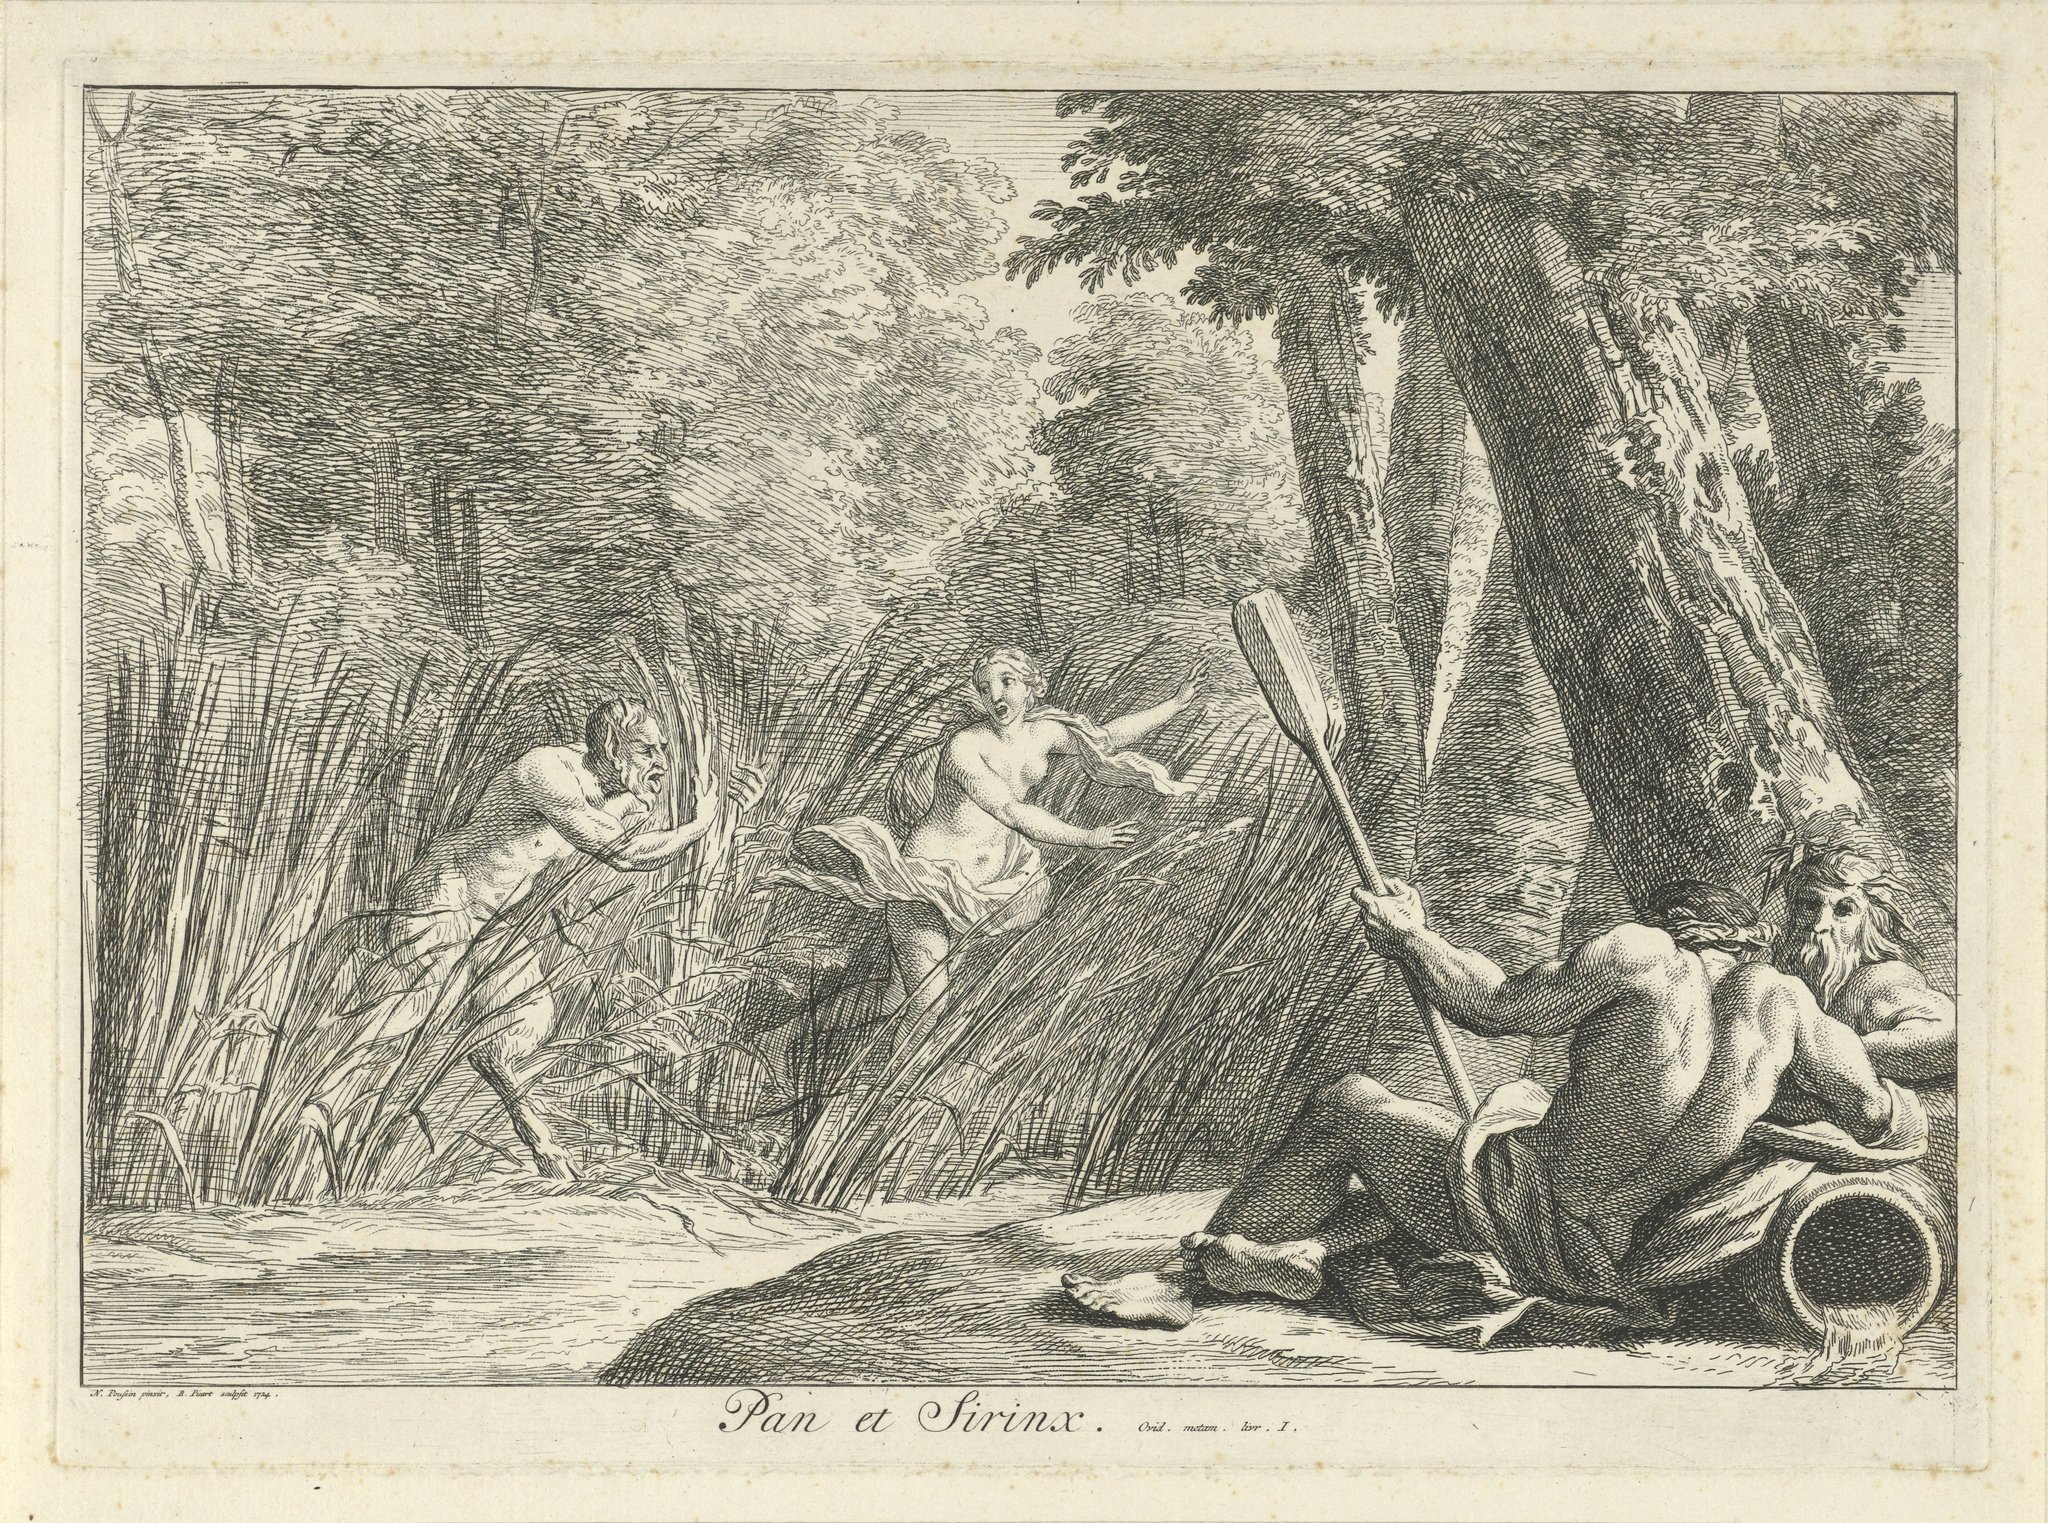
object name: print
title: Pan et Sirinx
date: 1724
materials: paper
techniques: engraving, etching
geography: amsterdam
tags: river-gods, syrinx changed into a reed: while fleeing from pan, the nymph syrinx is changed into reed by her sisters, the naiads (ovid, metamorphoses i 705)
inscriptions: collector's mark: Lugt 240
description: Tweede genummerde staat van deze prent opgenomen in: Impostures innocentes, ou recueil d'estampes d'apres divers peintres (...) par Bernard Picart (...) avec son elogue historique et le catalogue de ses ouvrages. Amsterdam: weduwe Bernard Picart, 1734.